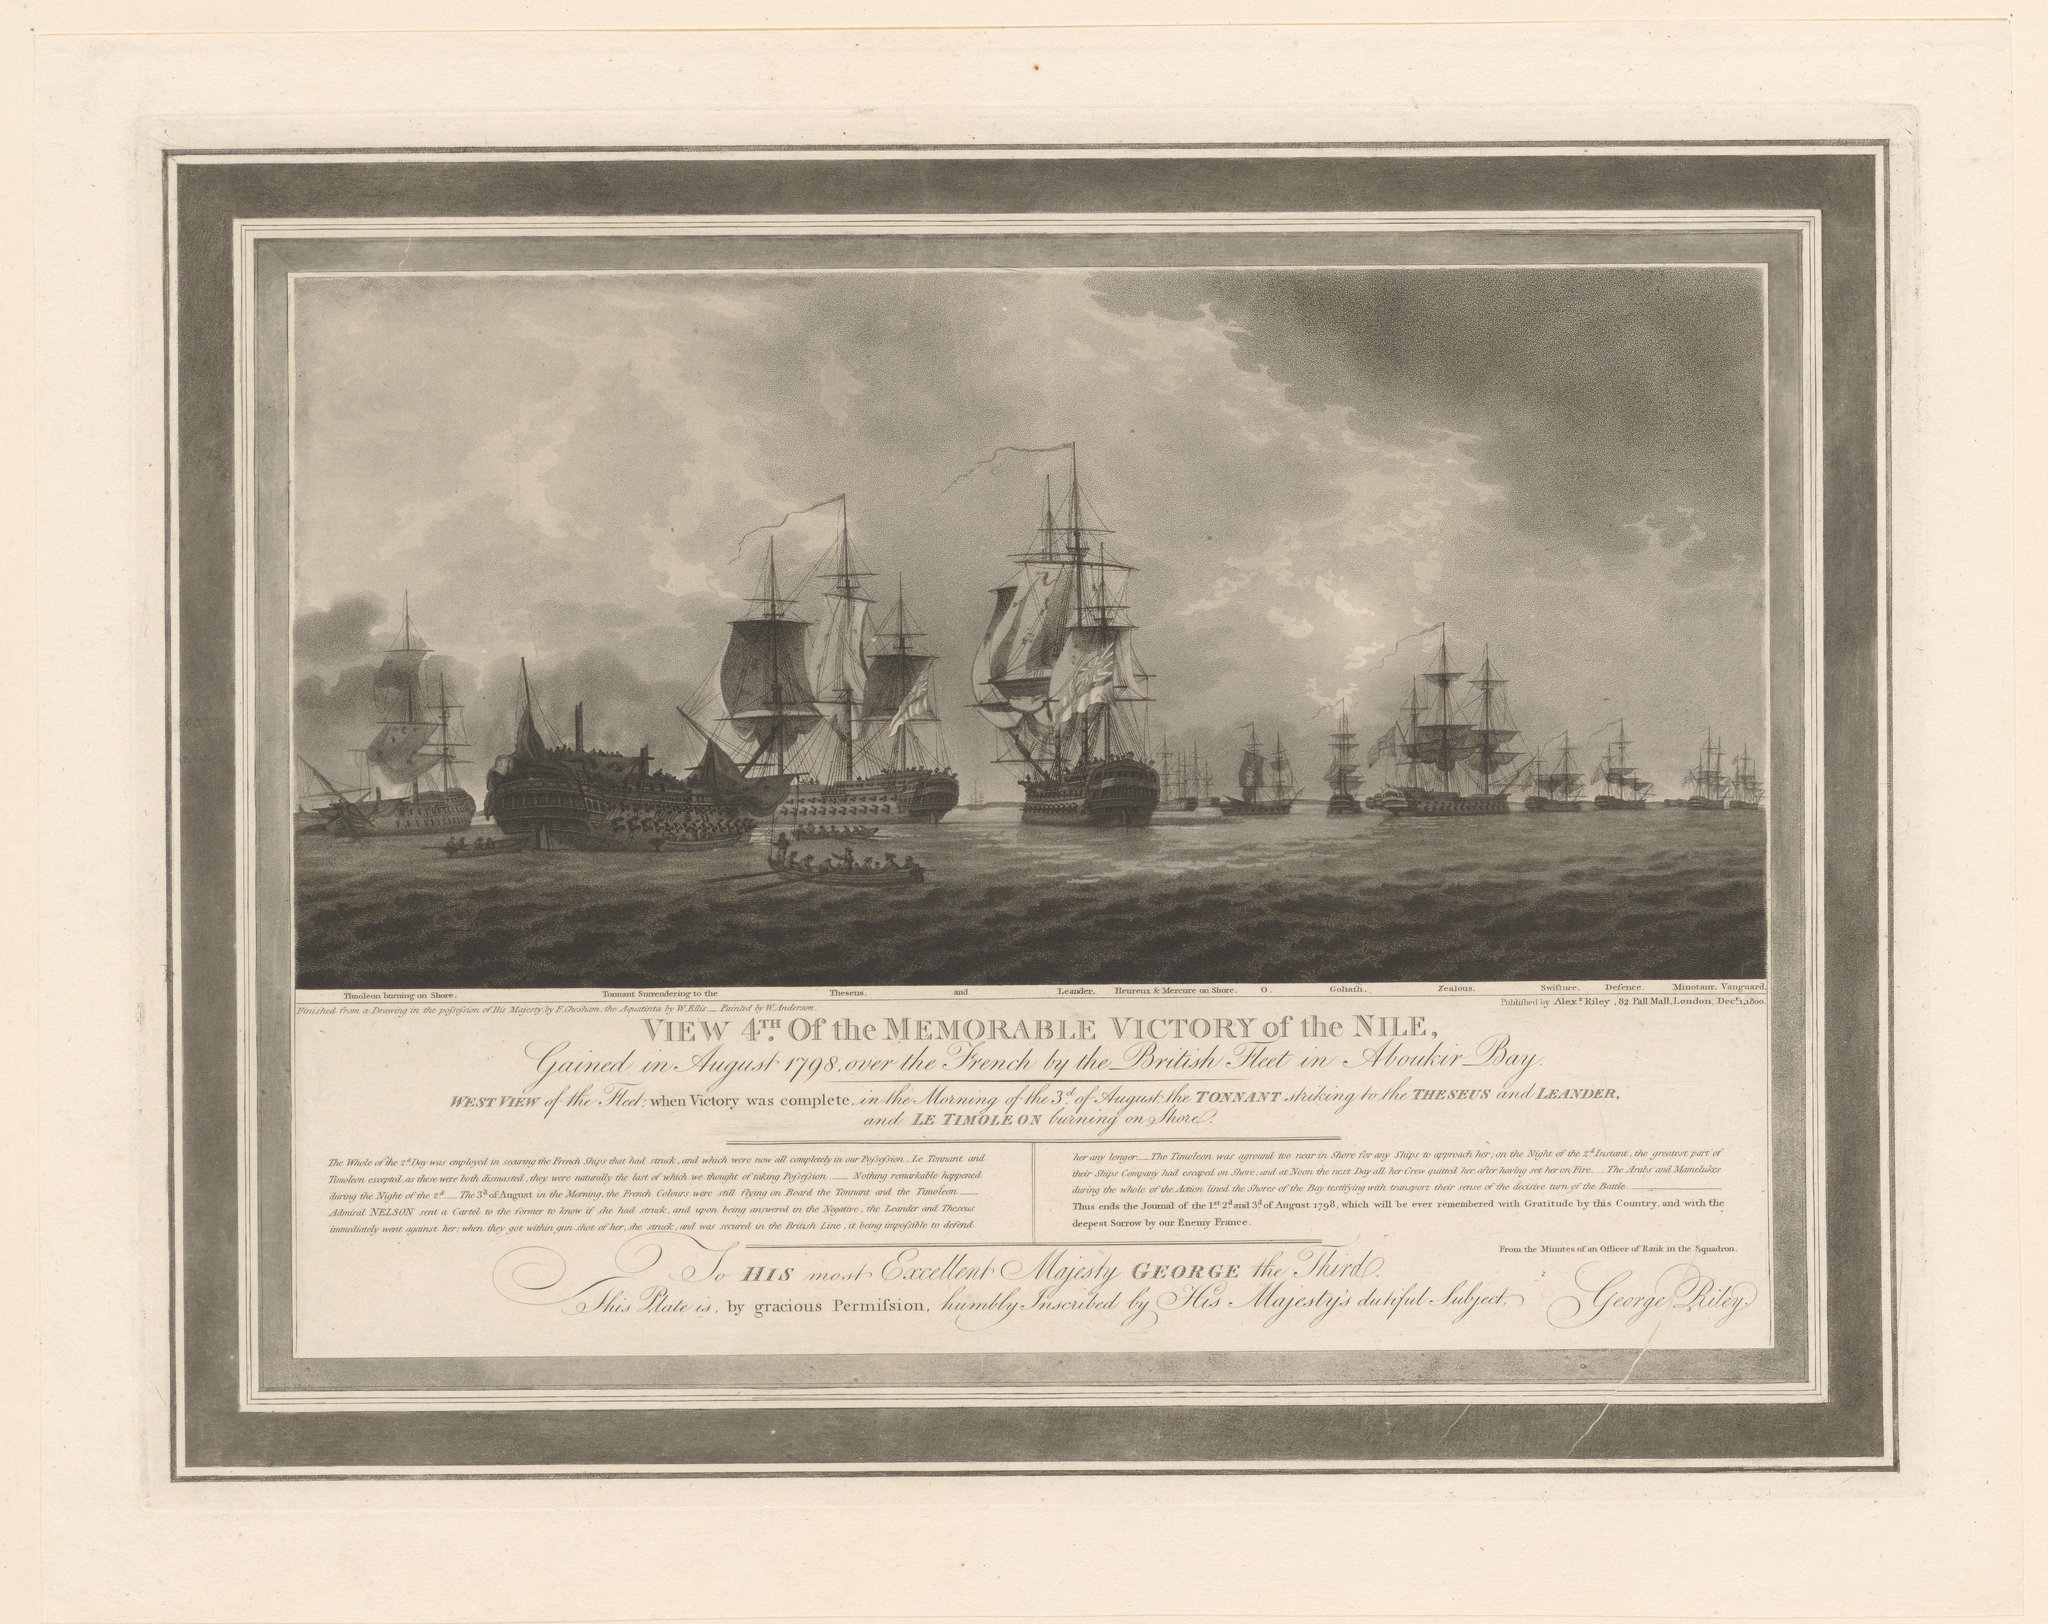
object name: print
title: View 4th. of the Memorable Victory of the Nile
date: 1800-1812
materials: paper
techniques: aquatint, etching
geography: london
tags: horatio nelson (hertog van bronte), sailing-ship, sailing-boat, battle, burning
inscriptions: collector's mark: Lugt 2228